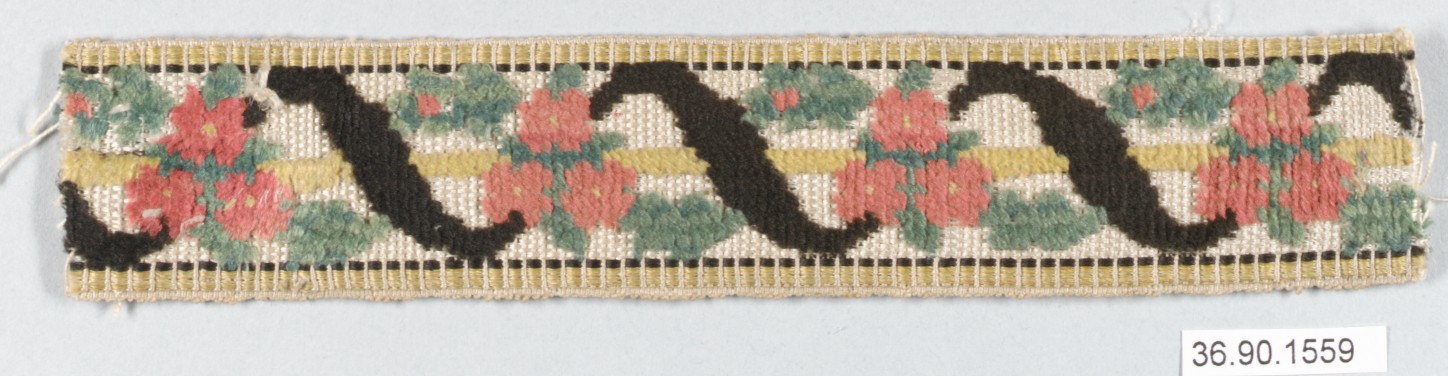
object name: galloon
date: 1701-1900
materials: silk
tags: flowers,leaves